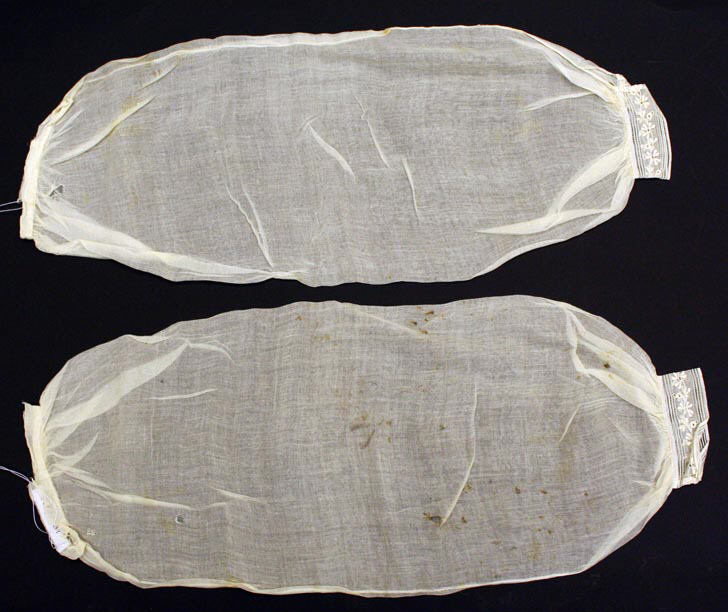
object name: undersleeves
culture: american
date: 1850-1859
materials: cotton